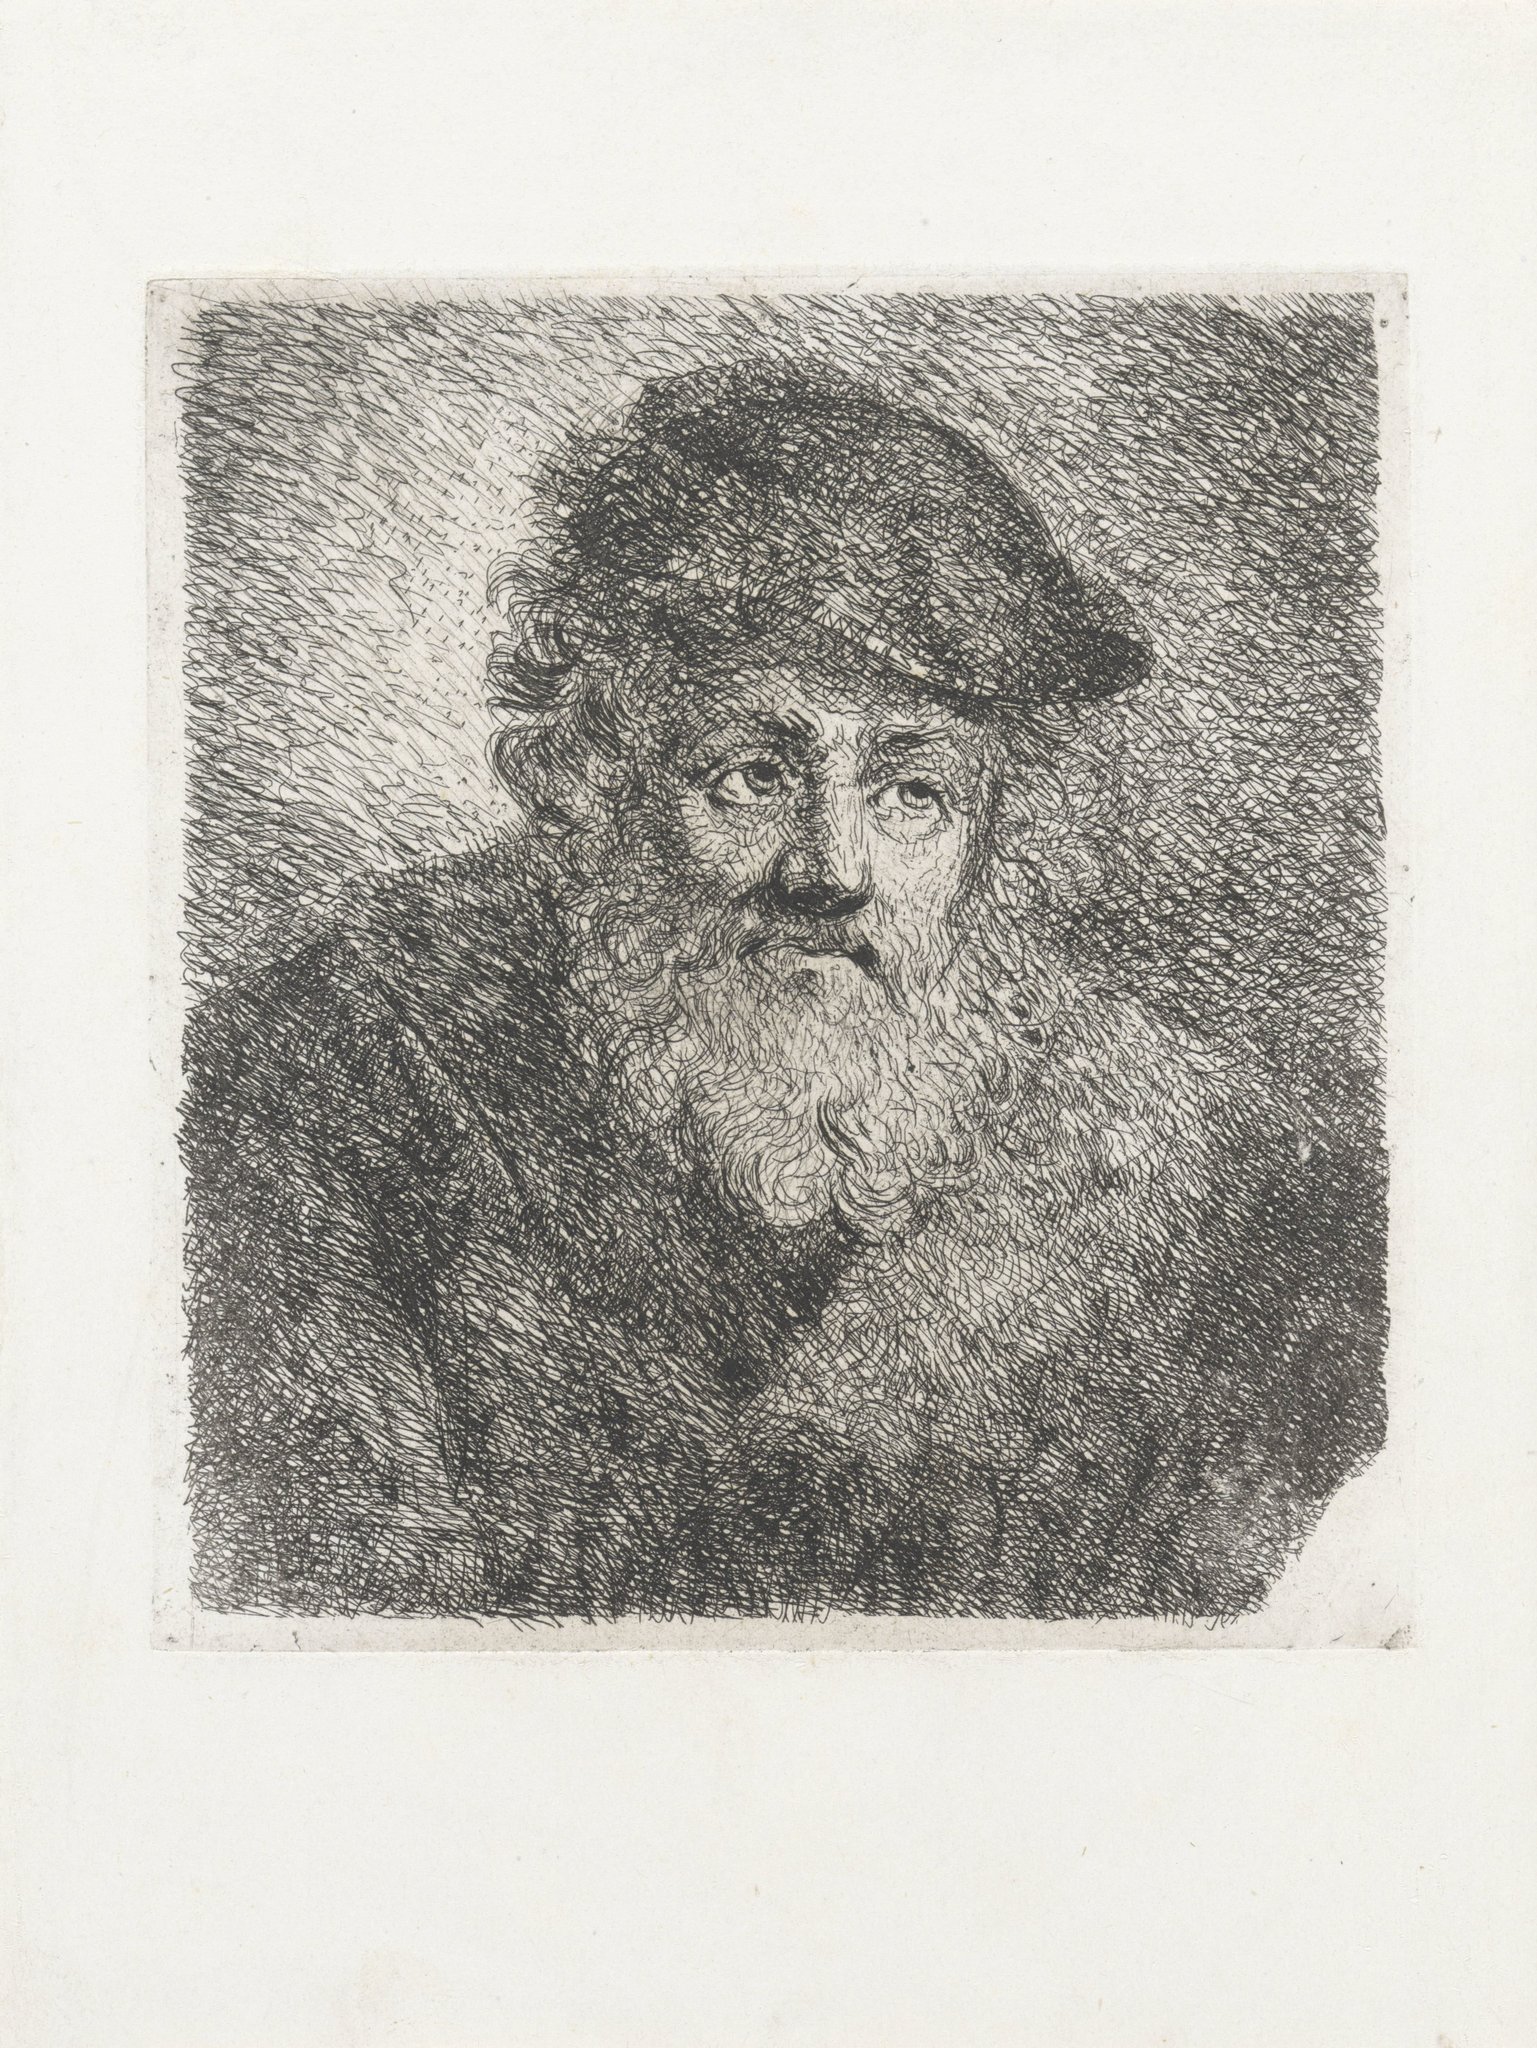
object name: print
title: Oude man met baard en muts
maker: cornelia scheffer-lamme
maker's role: print maker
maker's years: 1769-1839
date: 1784-1839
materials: paper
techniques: etching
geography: northern netherlands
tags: head-gear: cap (+ men's clothes), old man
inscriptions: collector's mark: Lugt 789a, collector's mark: Lugt 2760, collector's mark: Lugt 2228